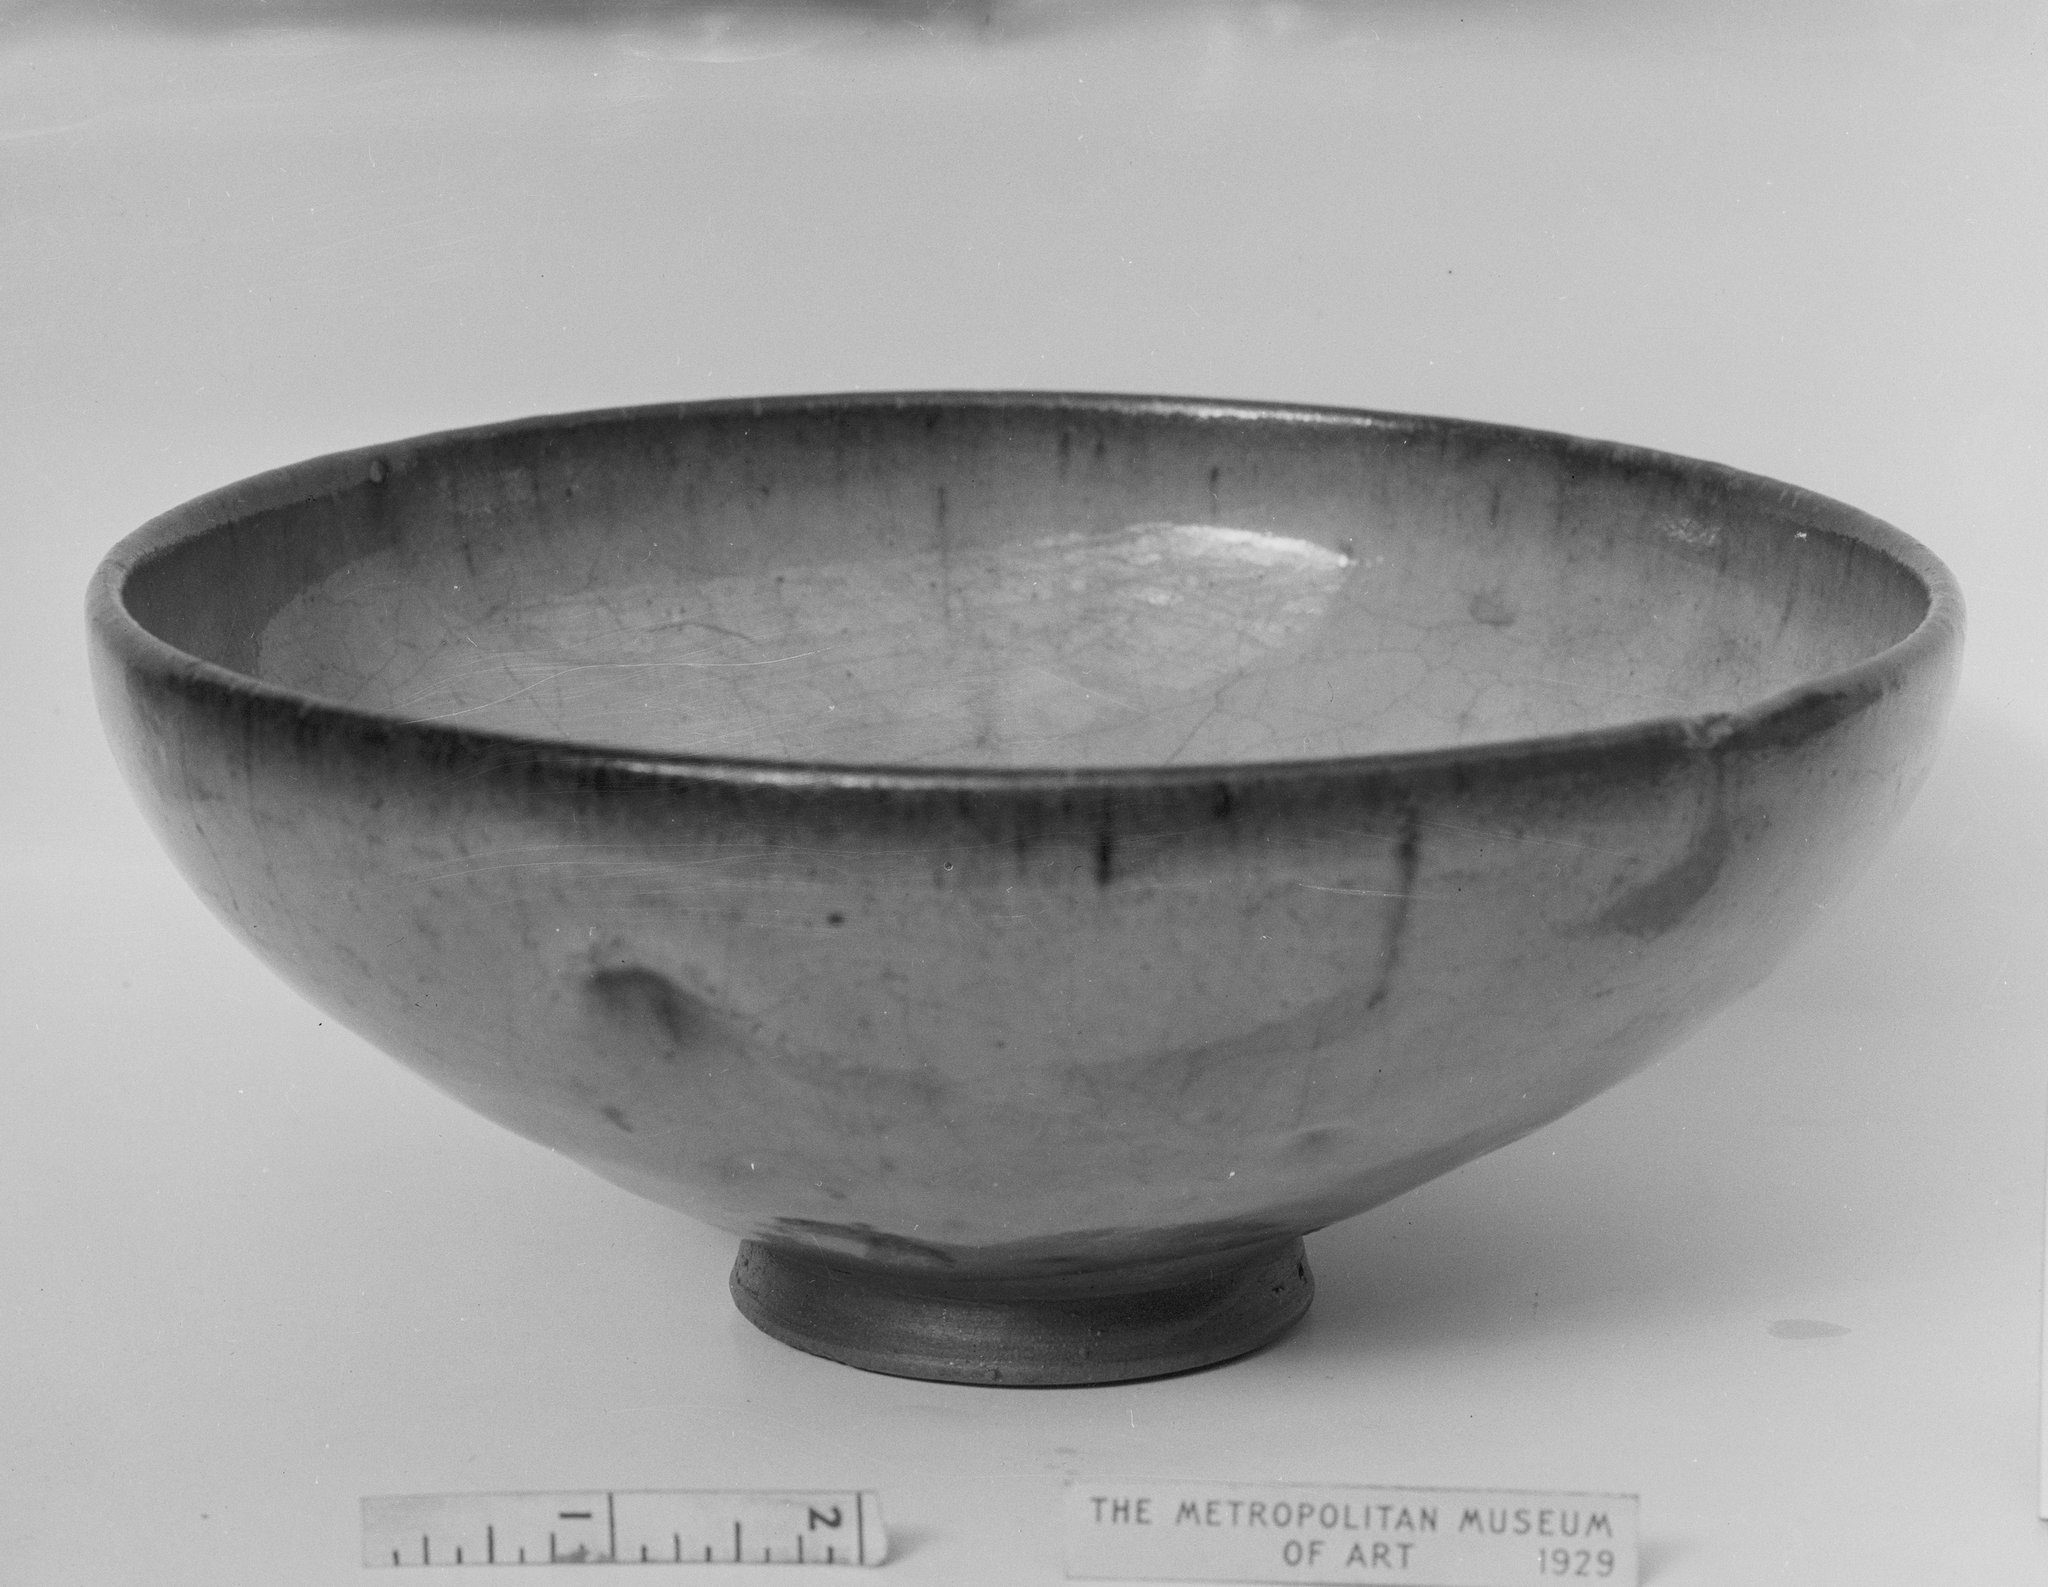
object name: bowl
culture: chinese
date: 1271-1368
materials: earthenware